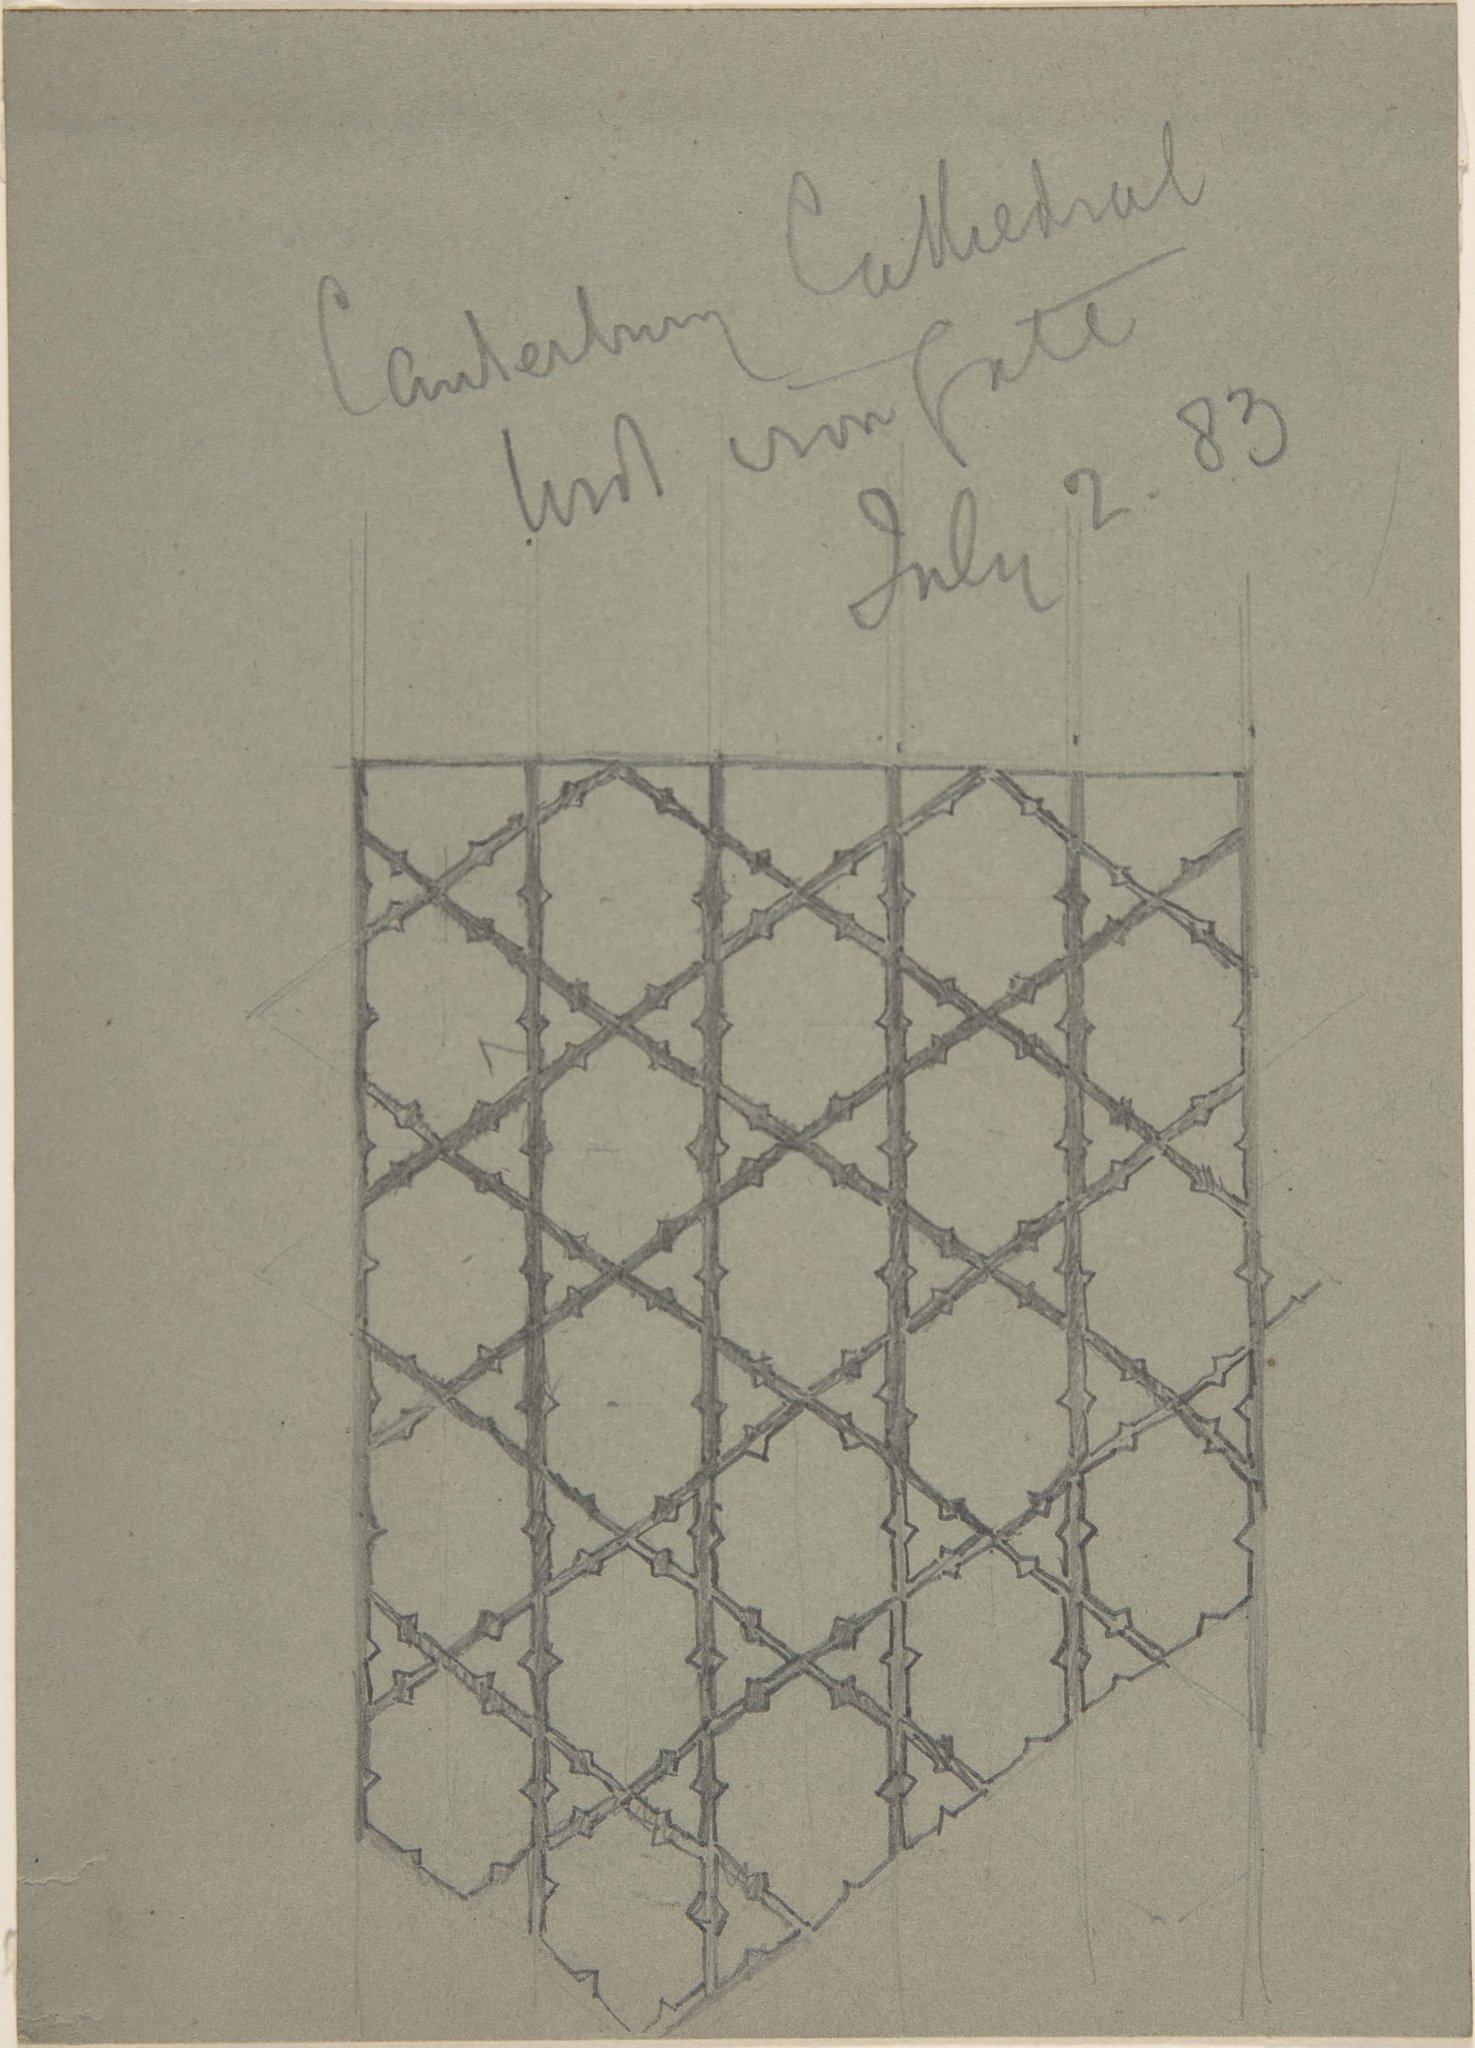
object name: drawing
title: Iron Gate, Canterbury Cathedral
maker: anonymous, british, 19th century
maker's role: artist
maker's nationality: british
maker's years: 1800-1900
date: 1883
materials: graphite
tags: gates